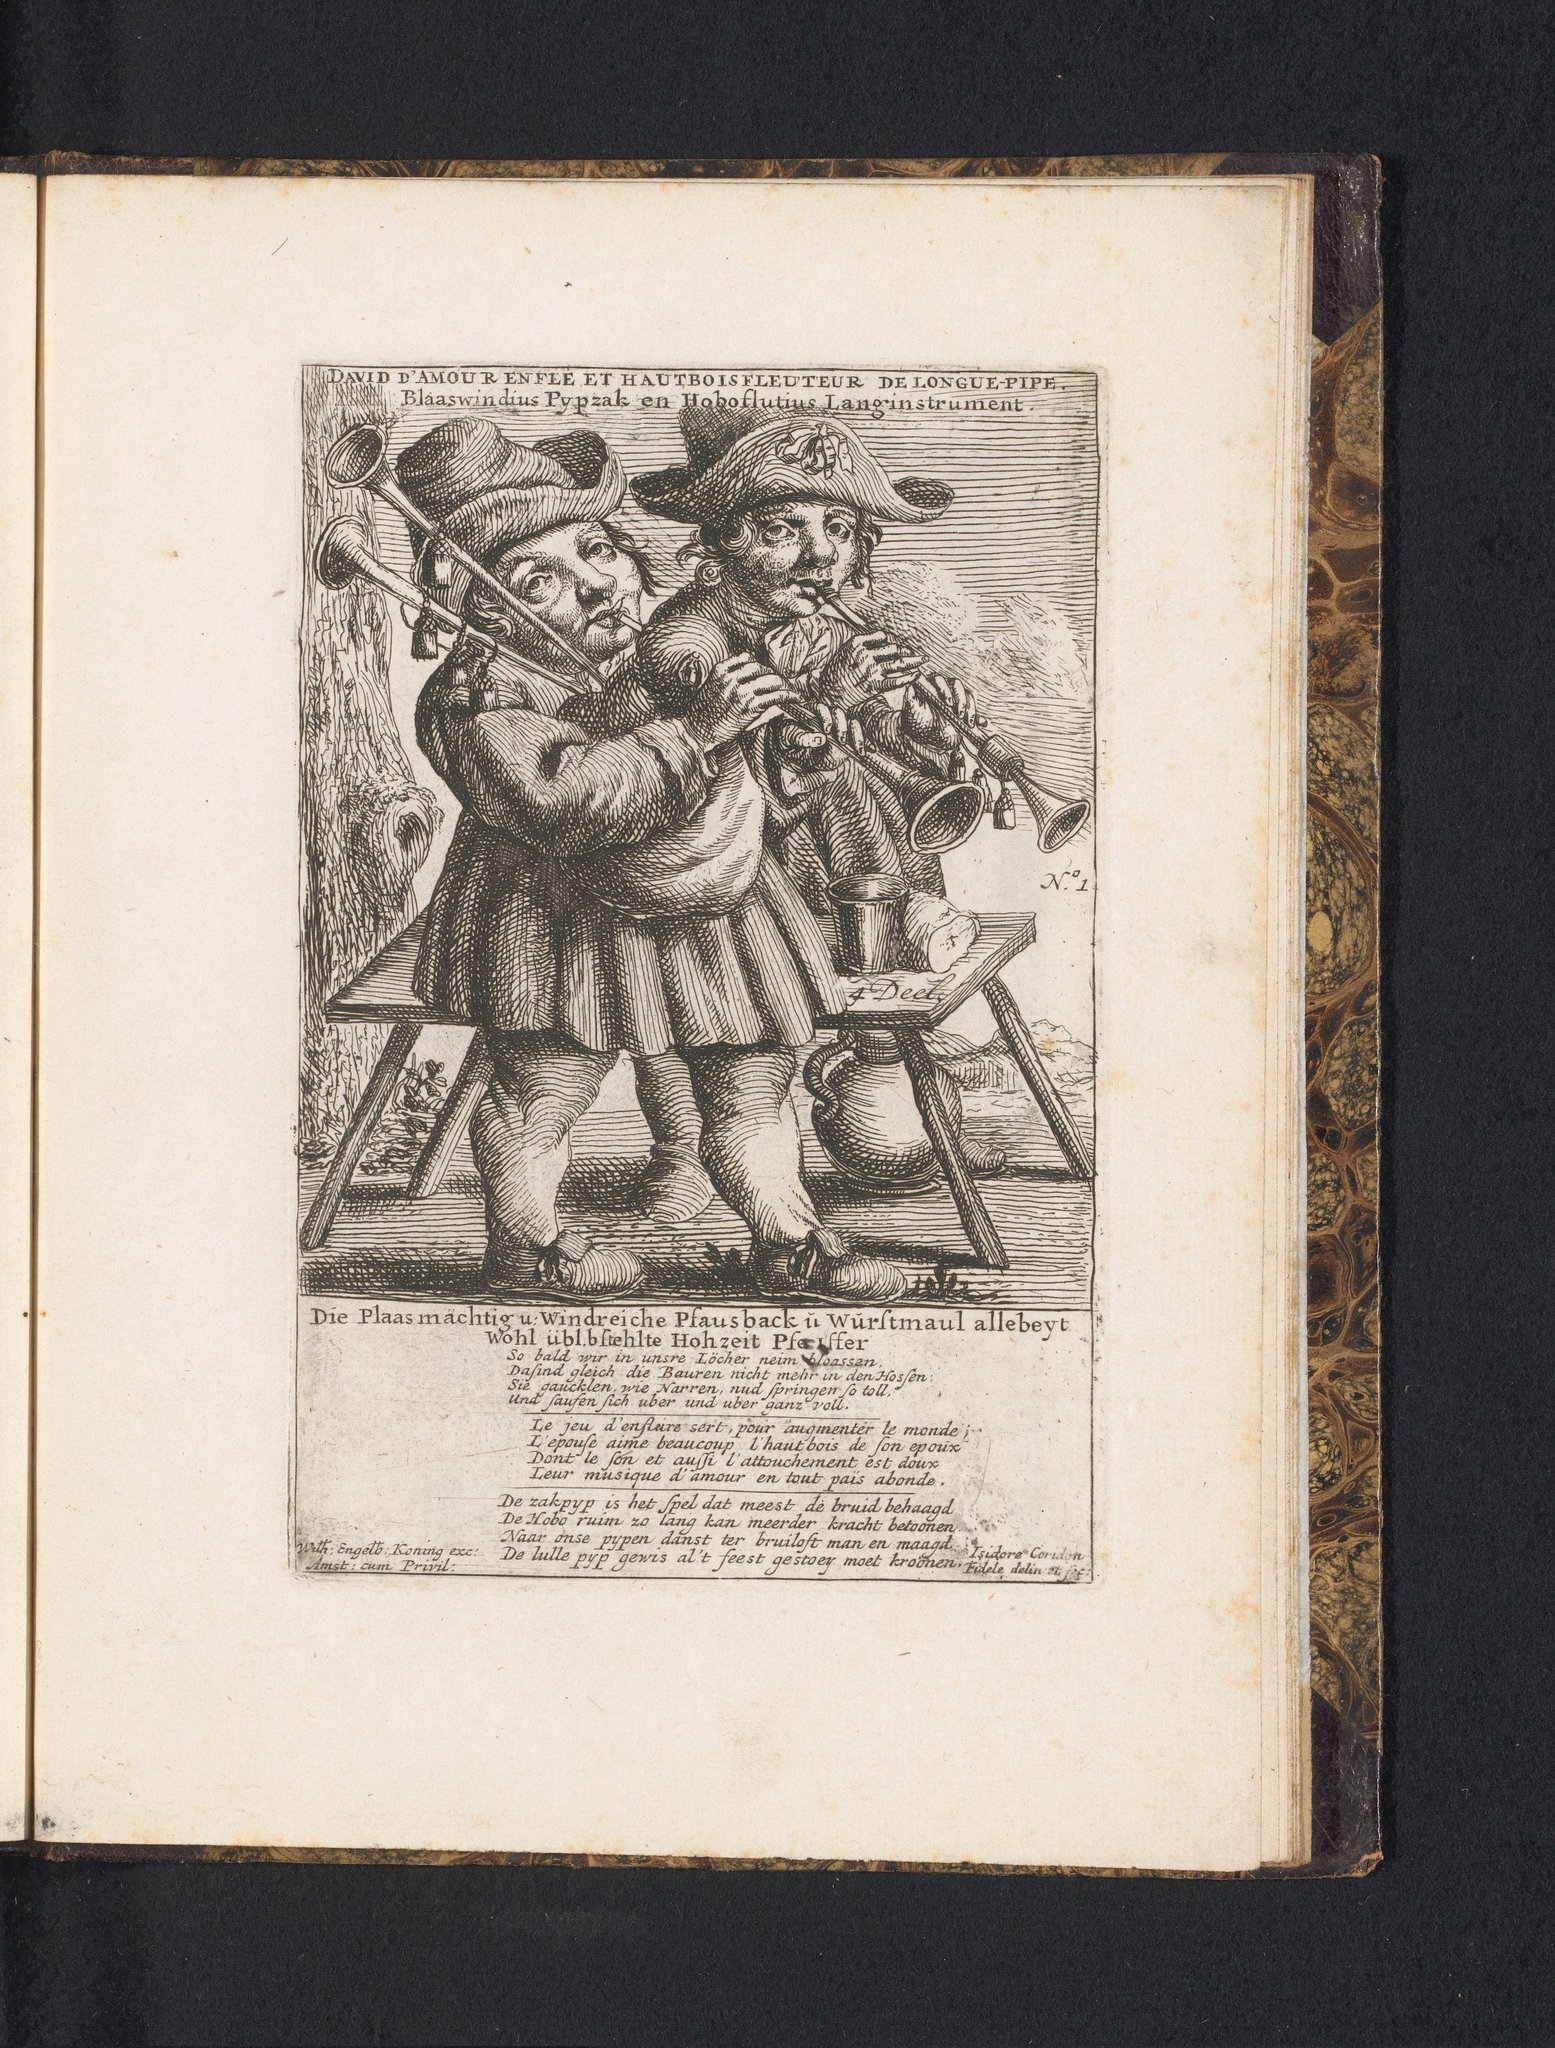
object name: caricature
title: Twee dwergen met doedelzak en fluit, 1720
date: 1718-1720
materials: paper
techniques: etching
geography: amsterdam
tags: bagpipe, musette (+ artist at work), caricatures (human types), flute, aulos, tibia (+ artist at work), little people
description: Twee kleine mensen die spelen op de doedelzak en de fluit. In het onderschrift verzen (met seksuele toespelingen) in het Duits, Frans en Nederlands. Afdruk zonder een decoratieve omlijsting. Genummerd op de tafel en rechts: 4 Deel No. 1. Onderdeel van deel IV (een serie van zes platen van dansende paren op een bruiloftsfeest) in de tweede Nederlandse gebonden uitgave uit 1720 (en deels gerelateerd aan de Windhandel in dat jaar) van een serie karikaturen van kleine mensen, bekend als Het Dwergentooneel.